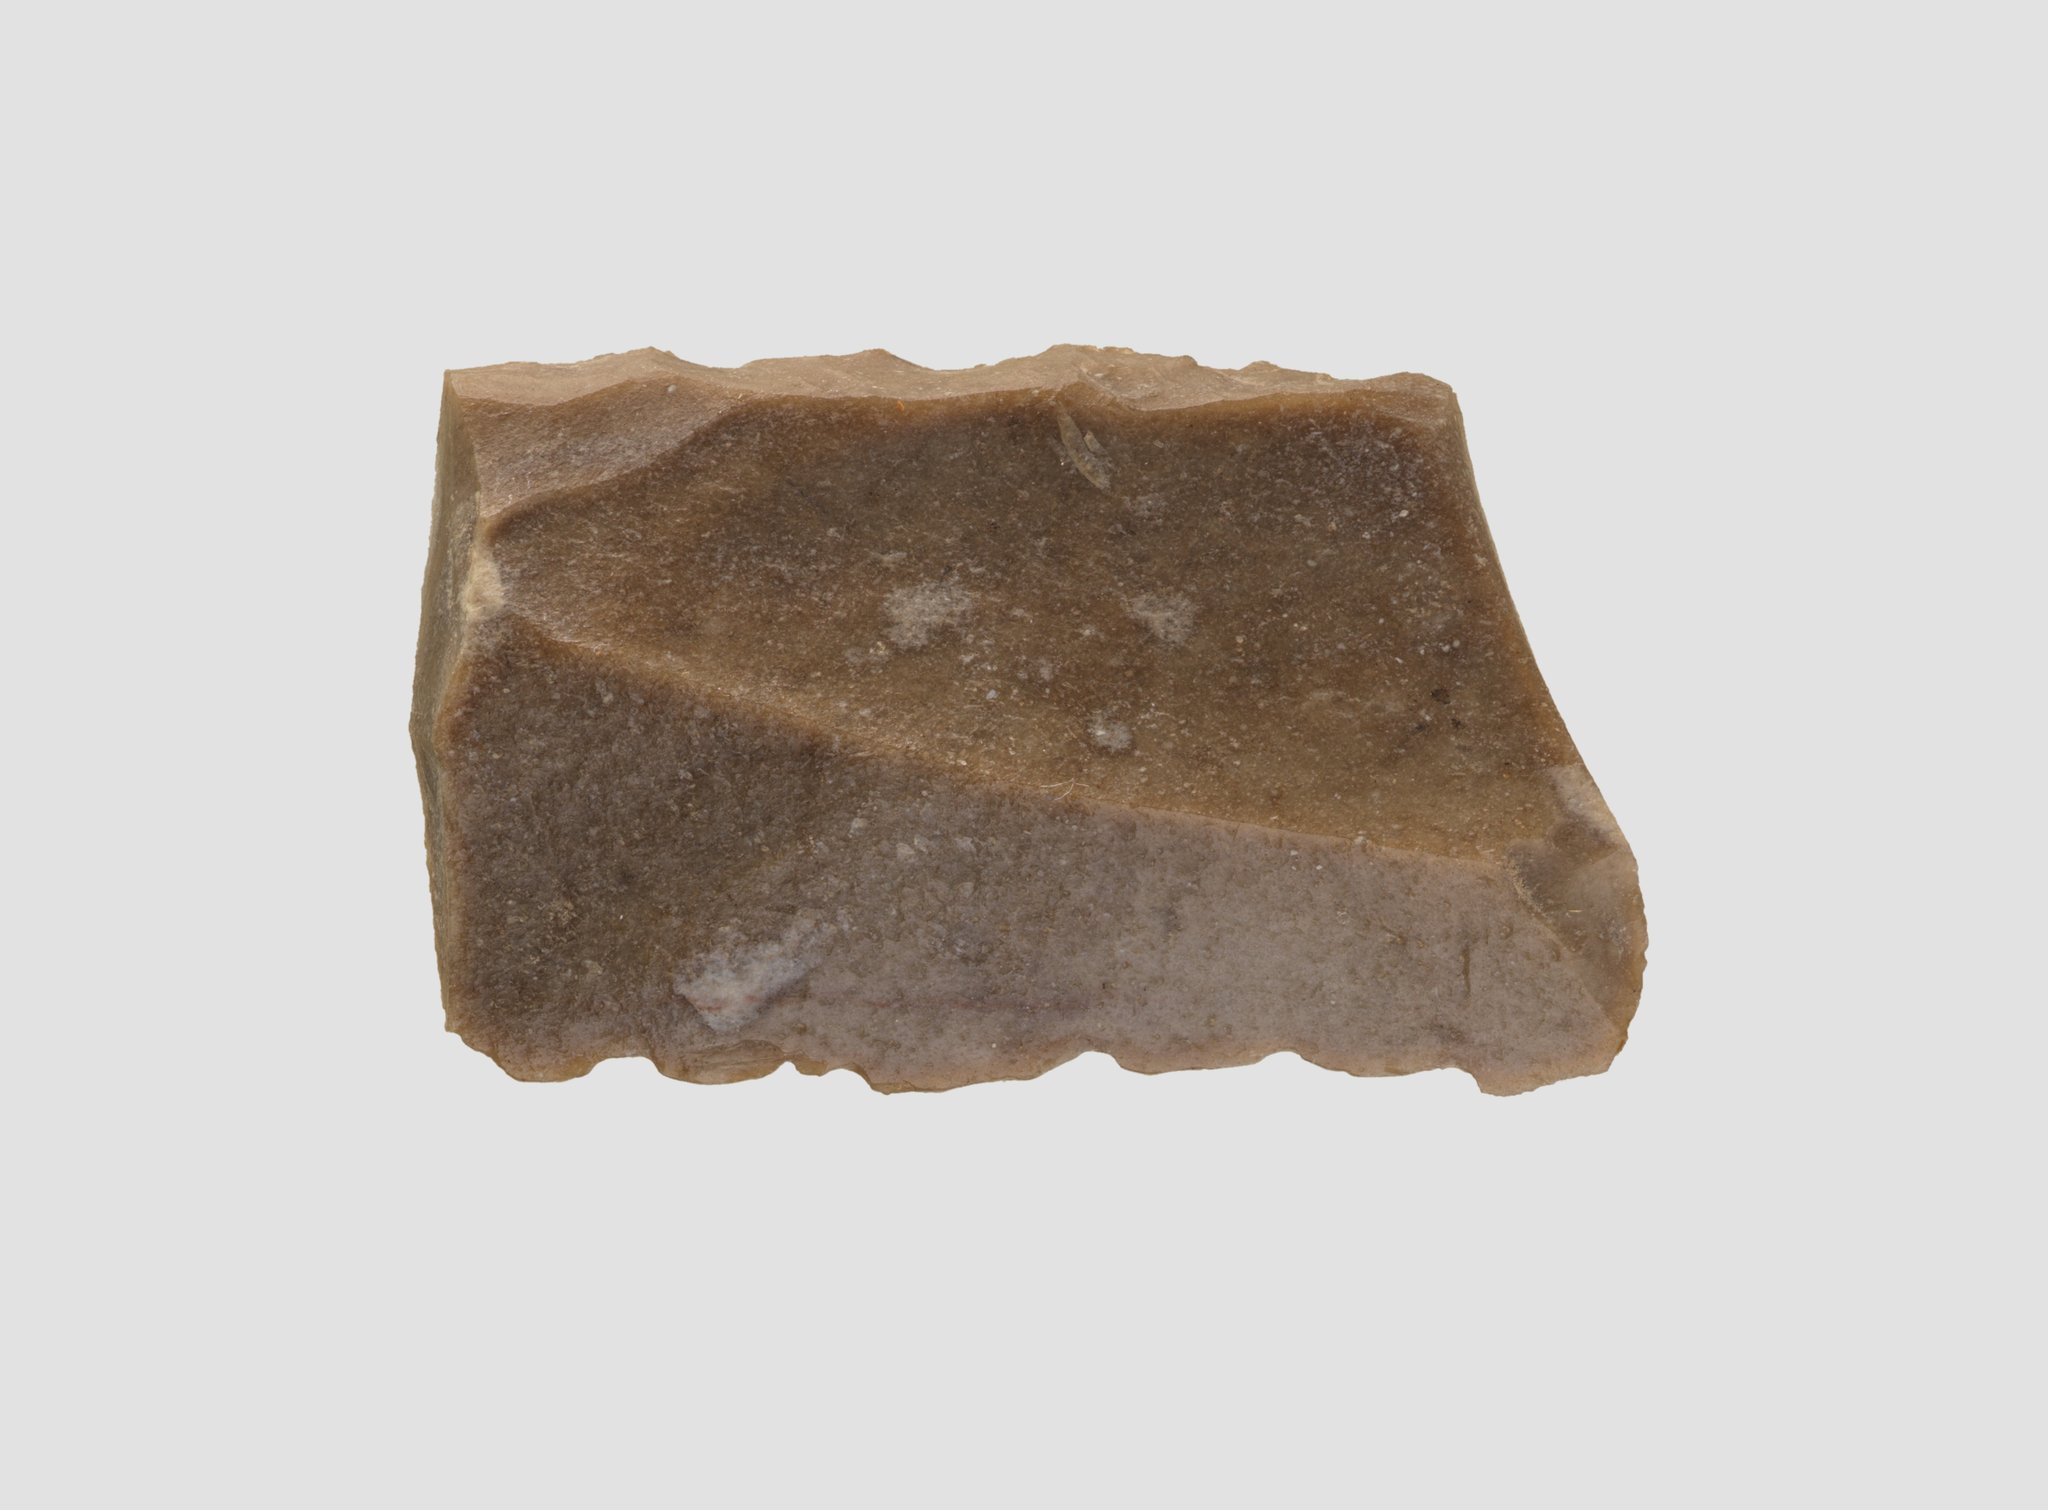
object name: knife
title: Blade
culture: ghassulian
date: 4600-3600 BCE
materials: stone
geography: levant